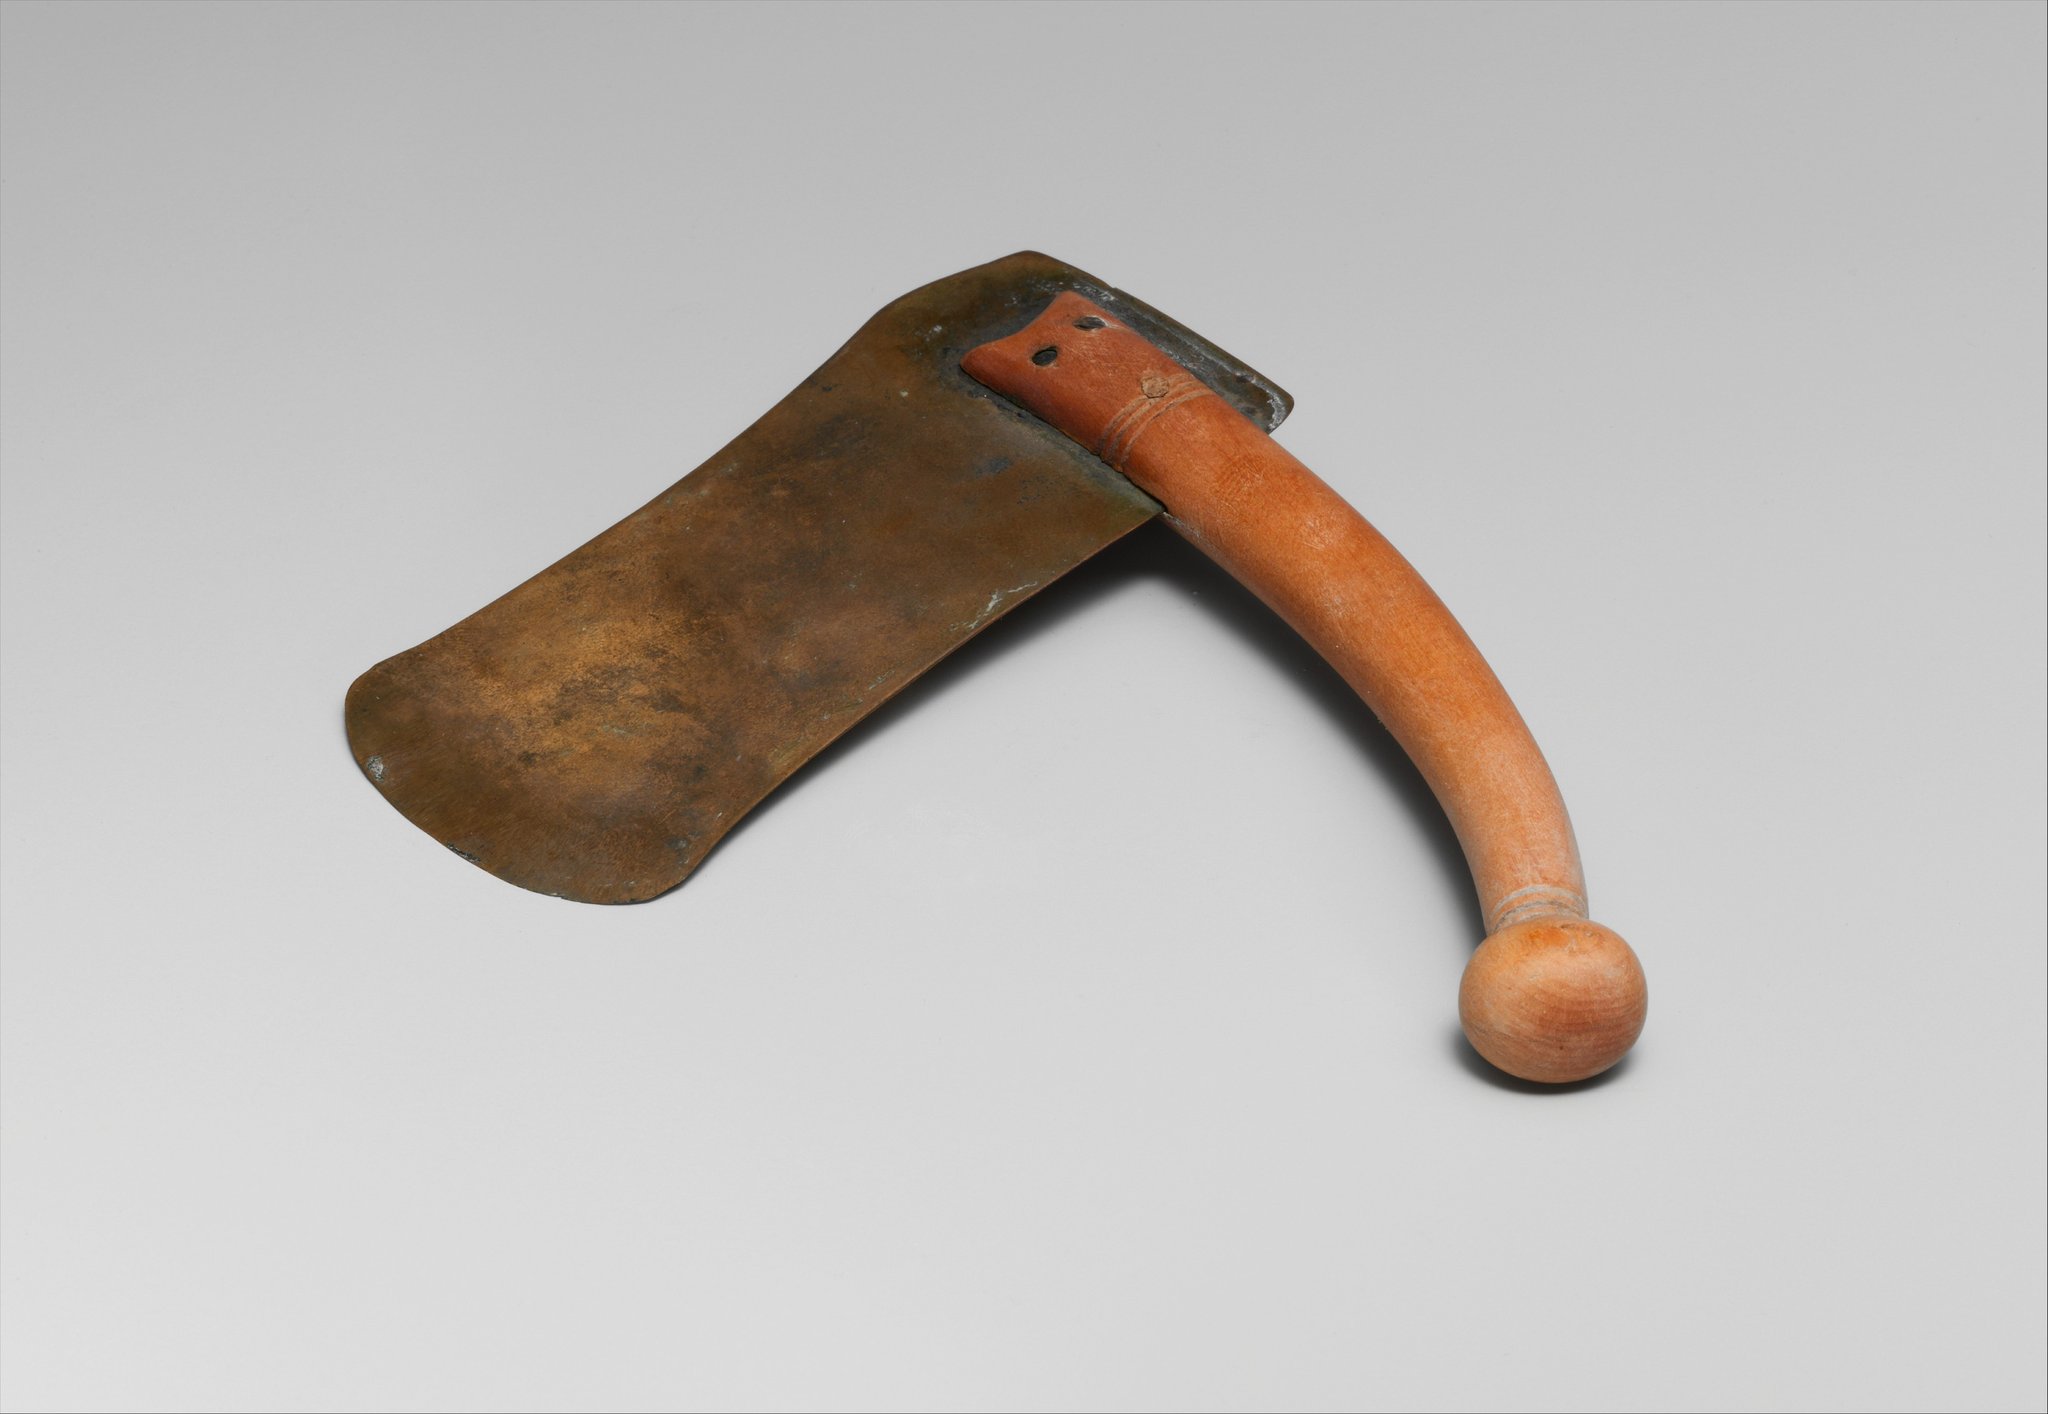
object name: razor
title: Razor Belonging to Hatnefer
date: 1492-1473 BCE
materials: wood, bronze, copper alloy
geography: egypt